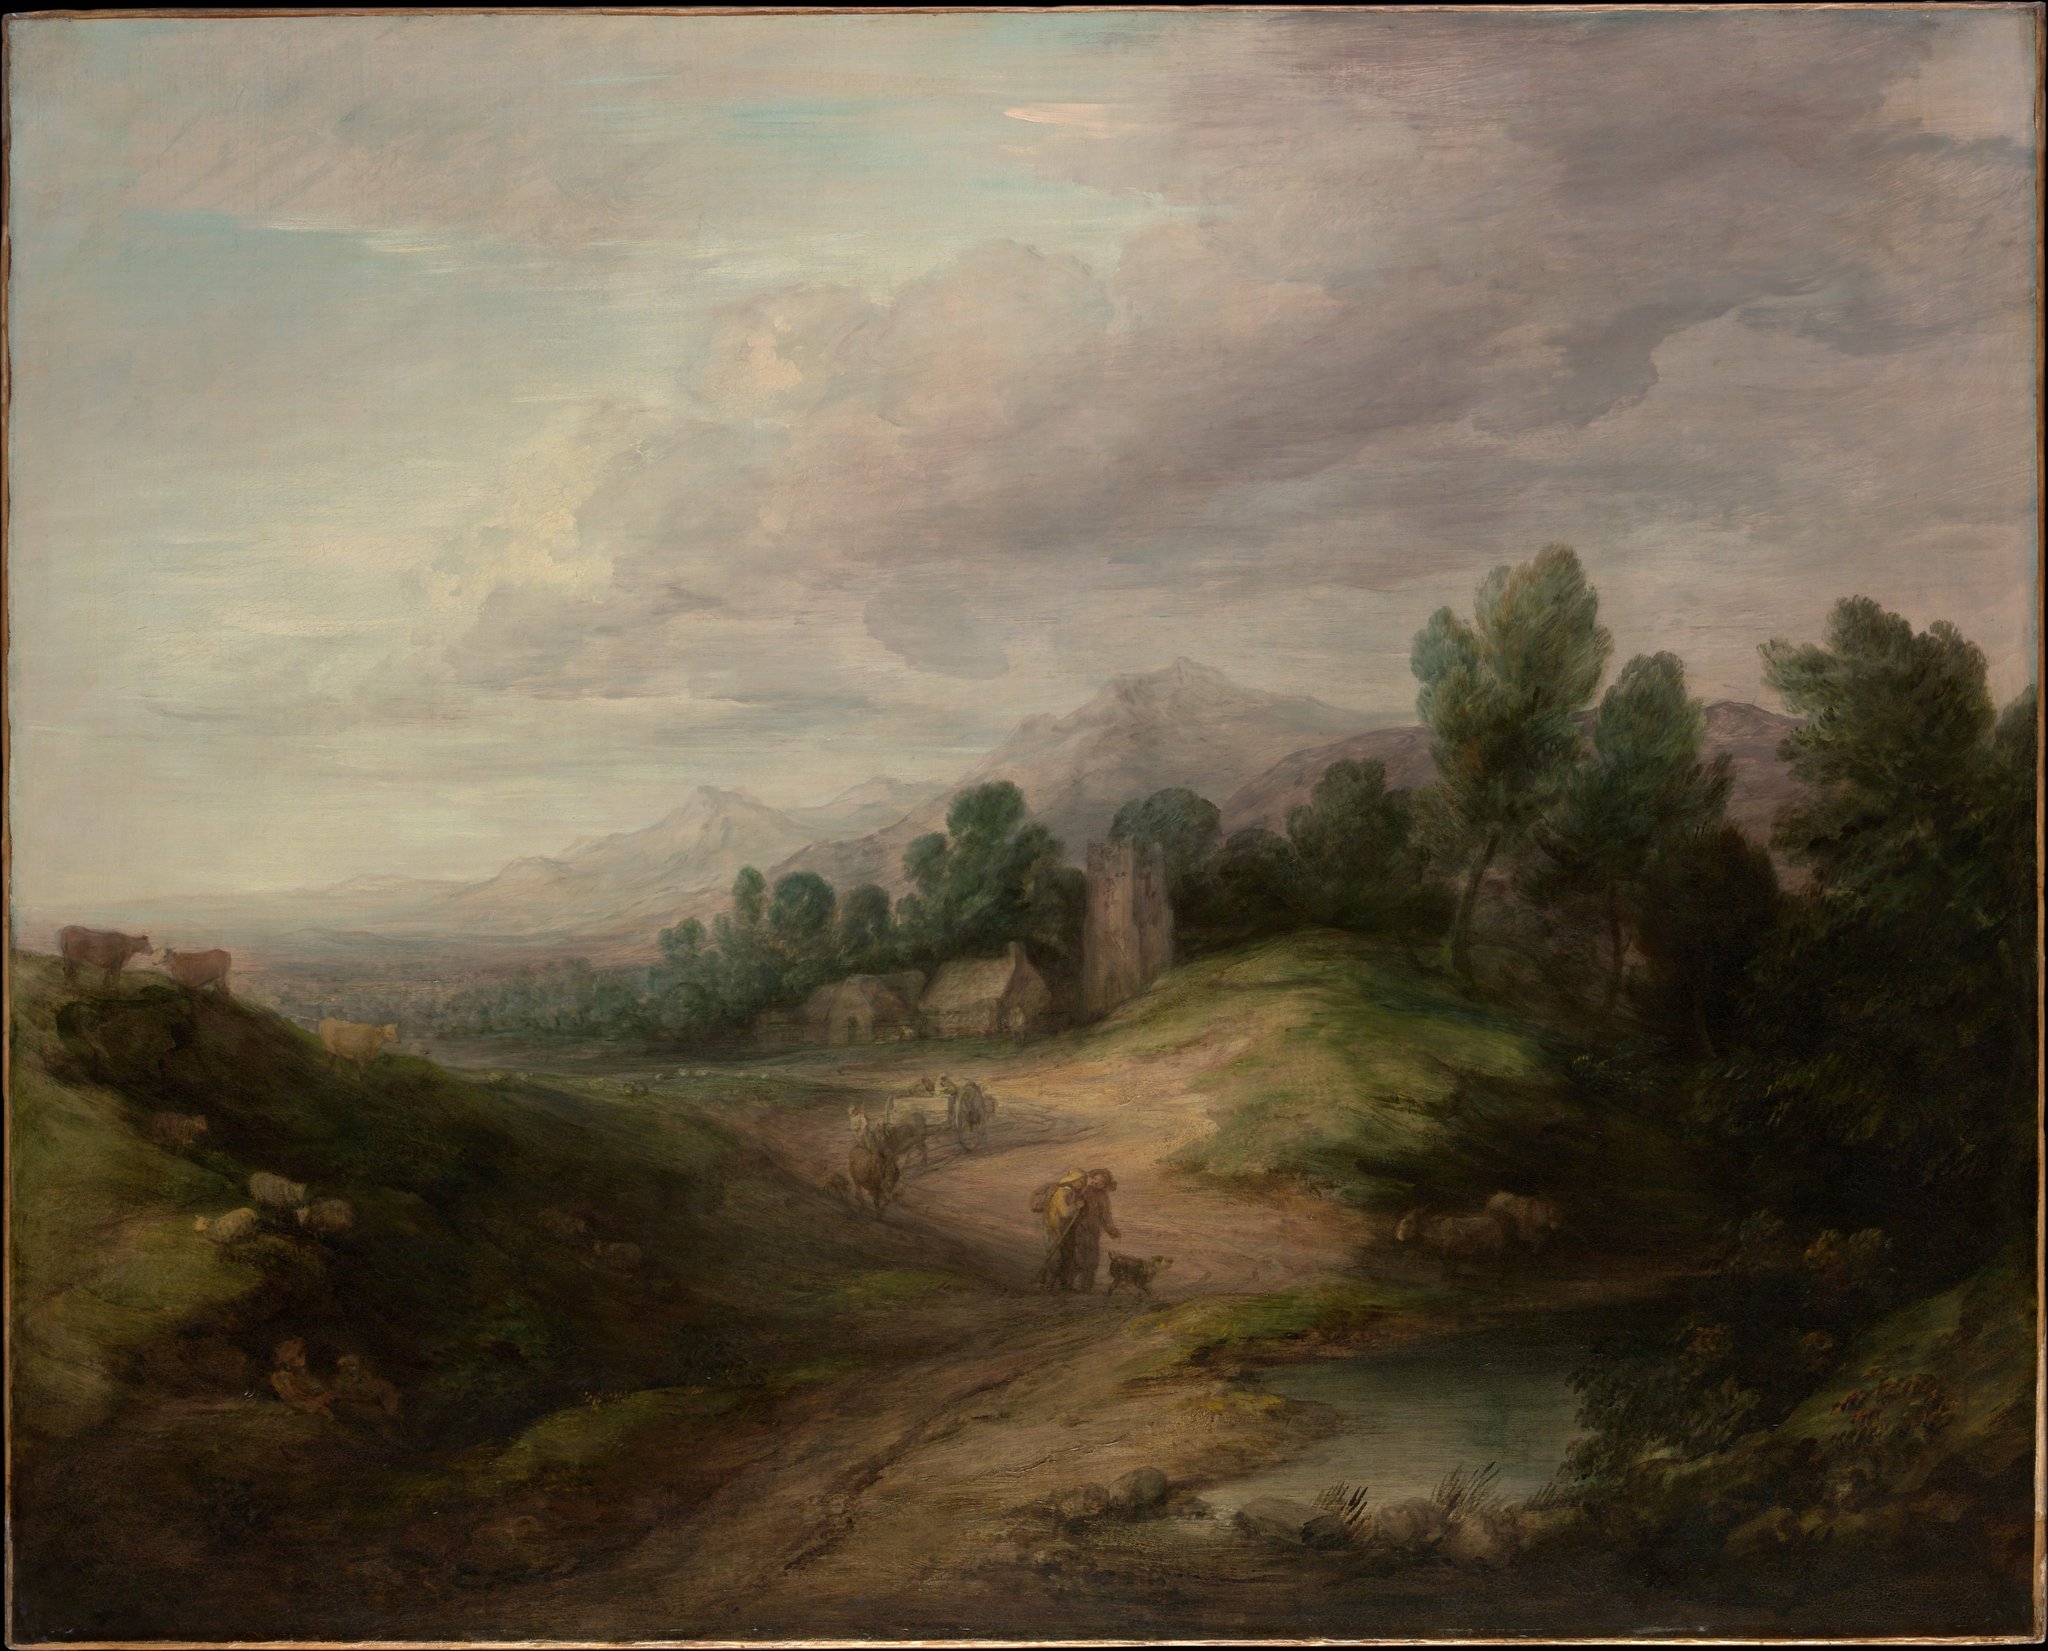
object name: painting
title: Wooded Upland Landscape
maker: thomas gainsborough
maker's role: artist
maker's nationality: british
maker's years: 1727-1788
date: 1783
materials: canvas, oil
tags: landscapes,wagons